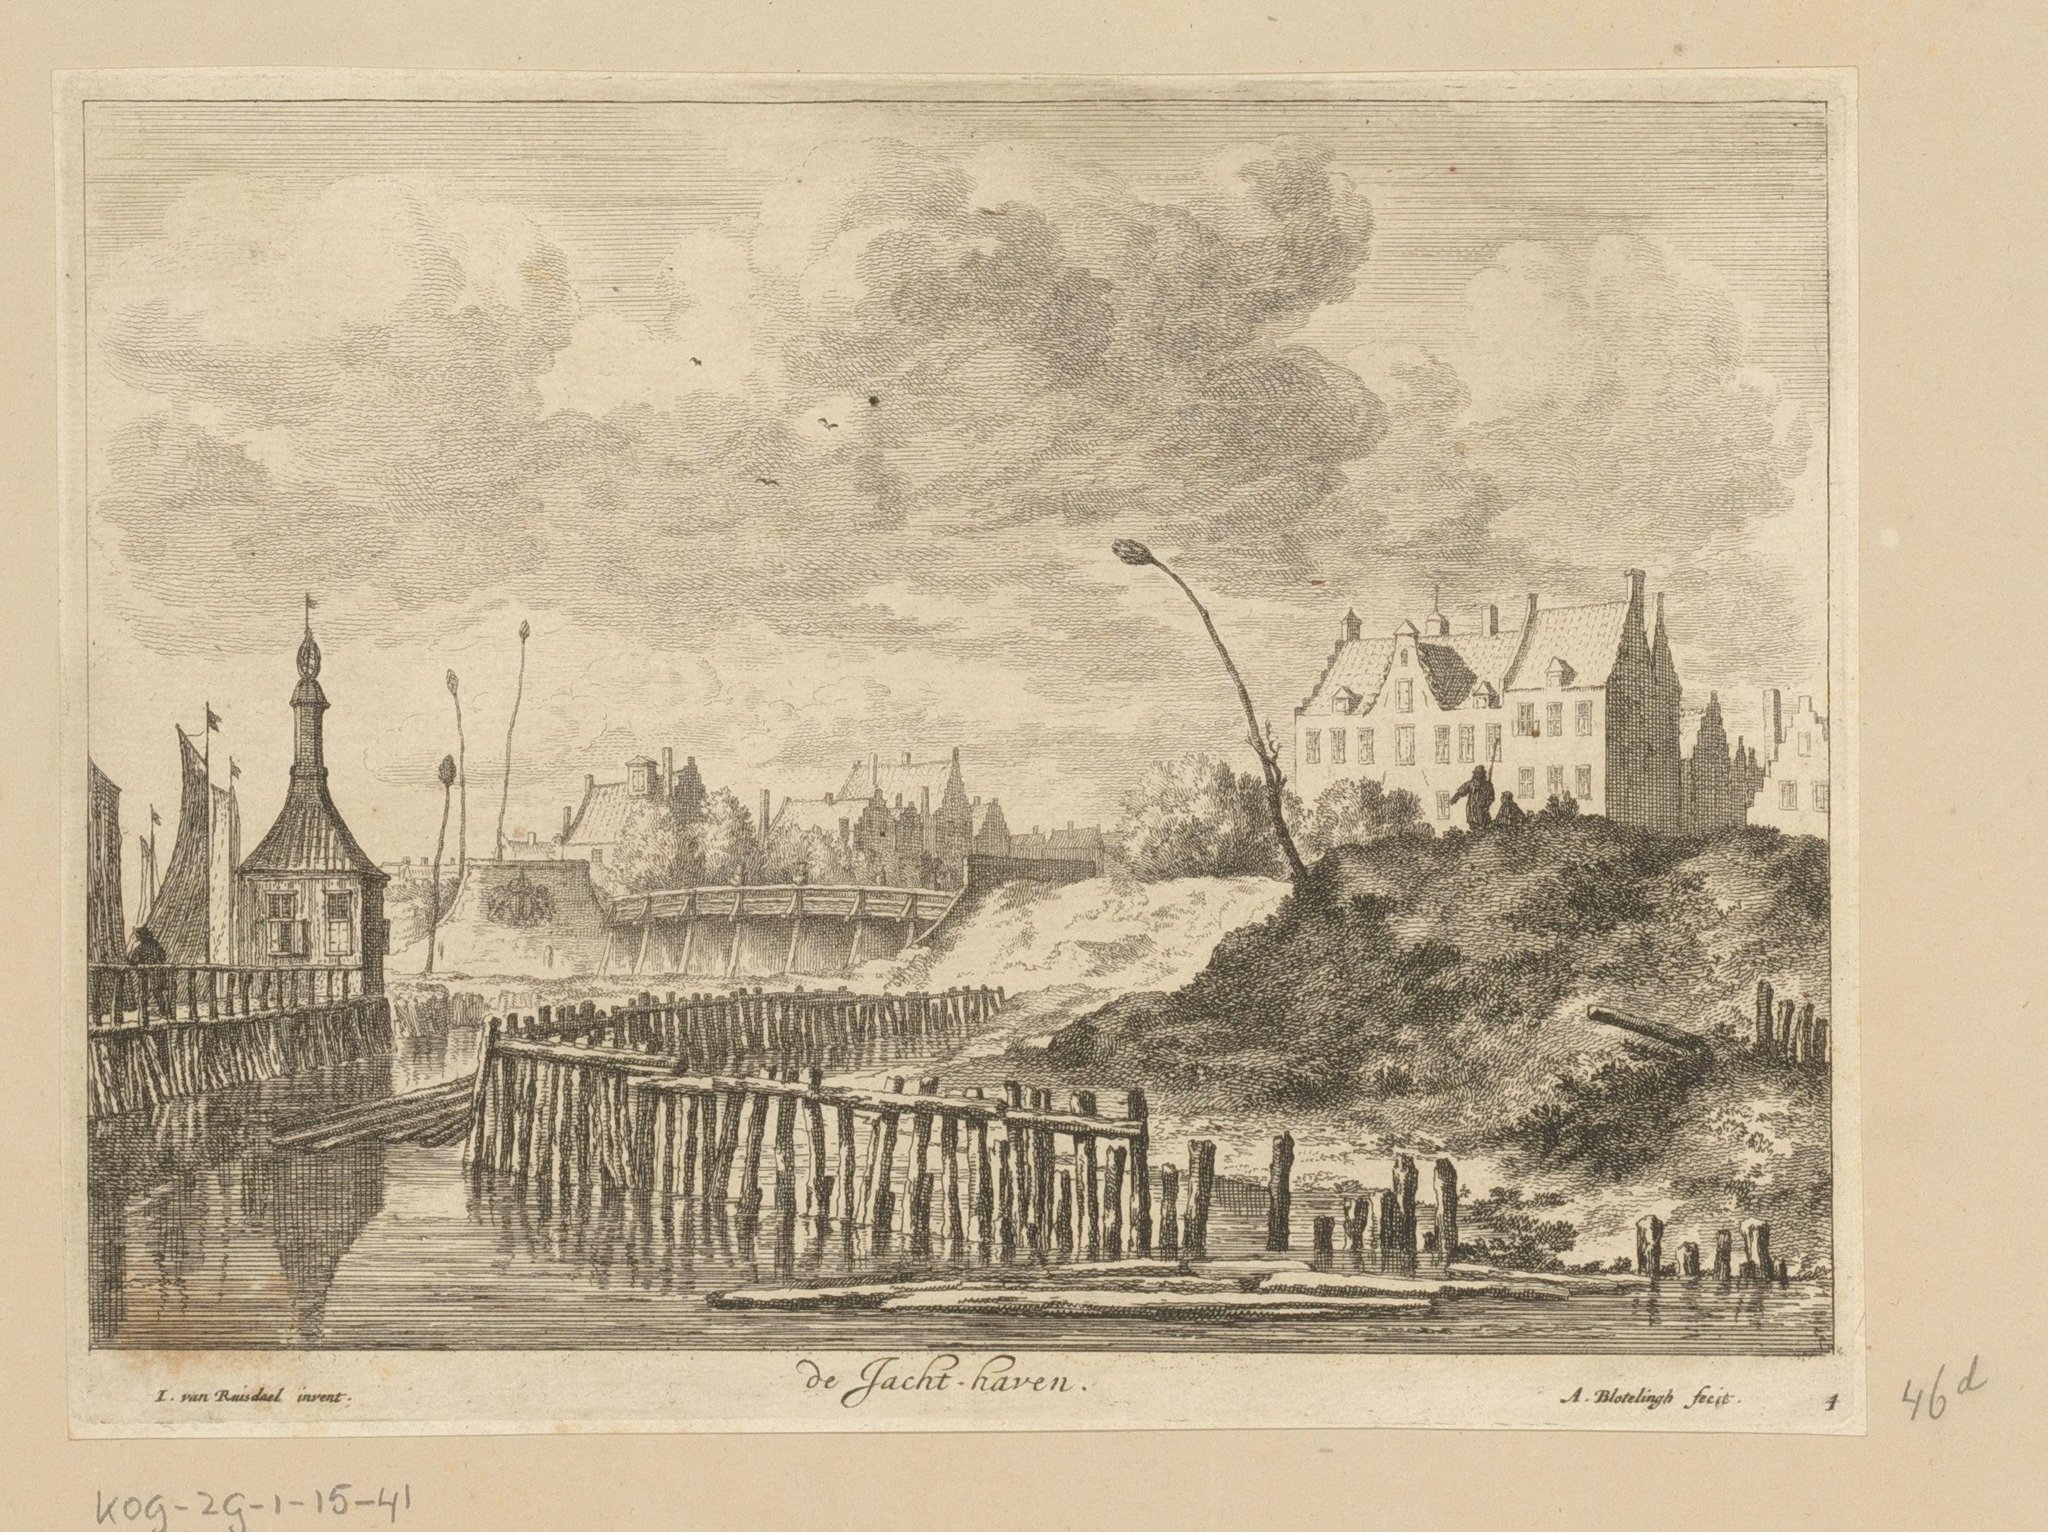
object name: print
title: Amstelgezichten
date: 1655-1690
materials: paper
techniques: engraving, etching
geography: amsterdam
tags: harbour, rowing-boat, canoe, etc., bridge in city across river, canal, etc.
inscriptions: collector's mark: Lugt 1641, stamp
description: Rechtsonder genummerd: 4. Onderwerpsrubrieken binnen de Atlas Zeden en Gewoonten: Handel, nijverheid en verkeer, Bruggen.